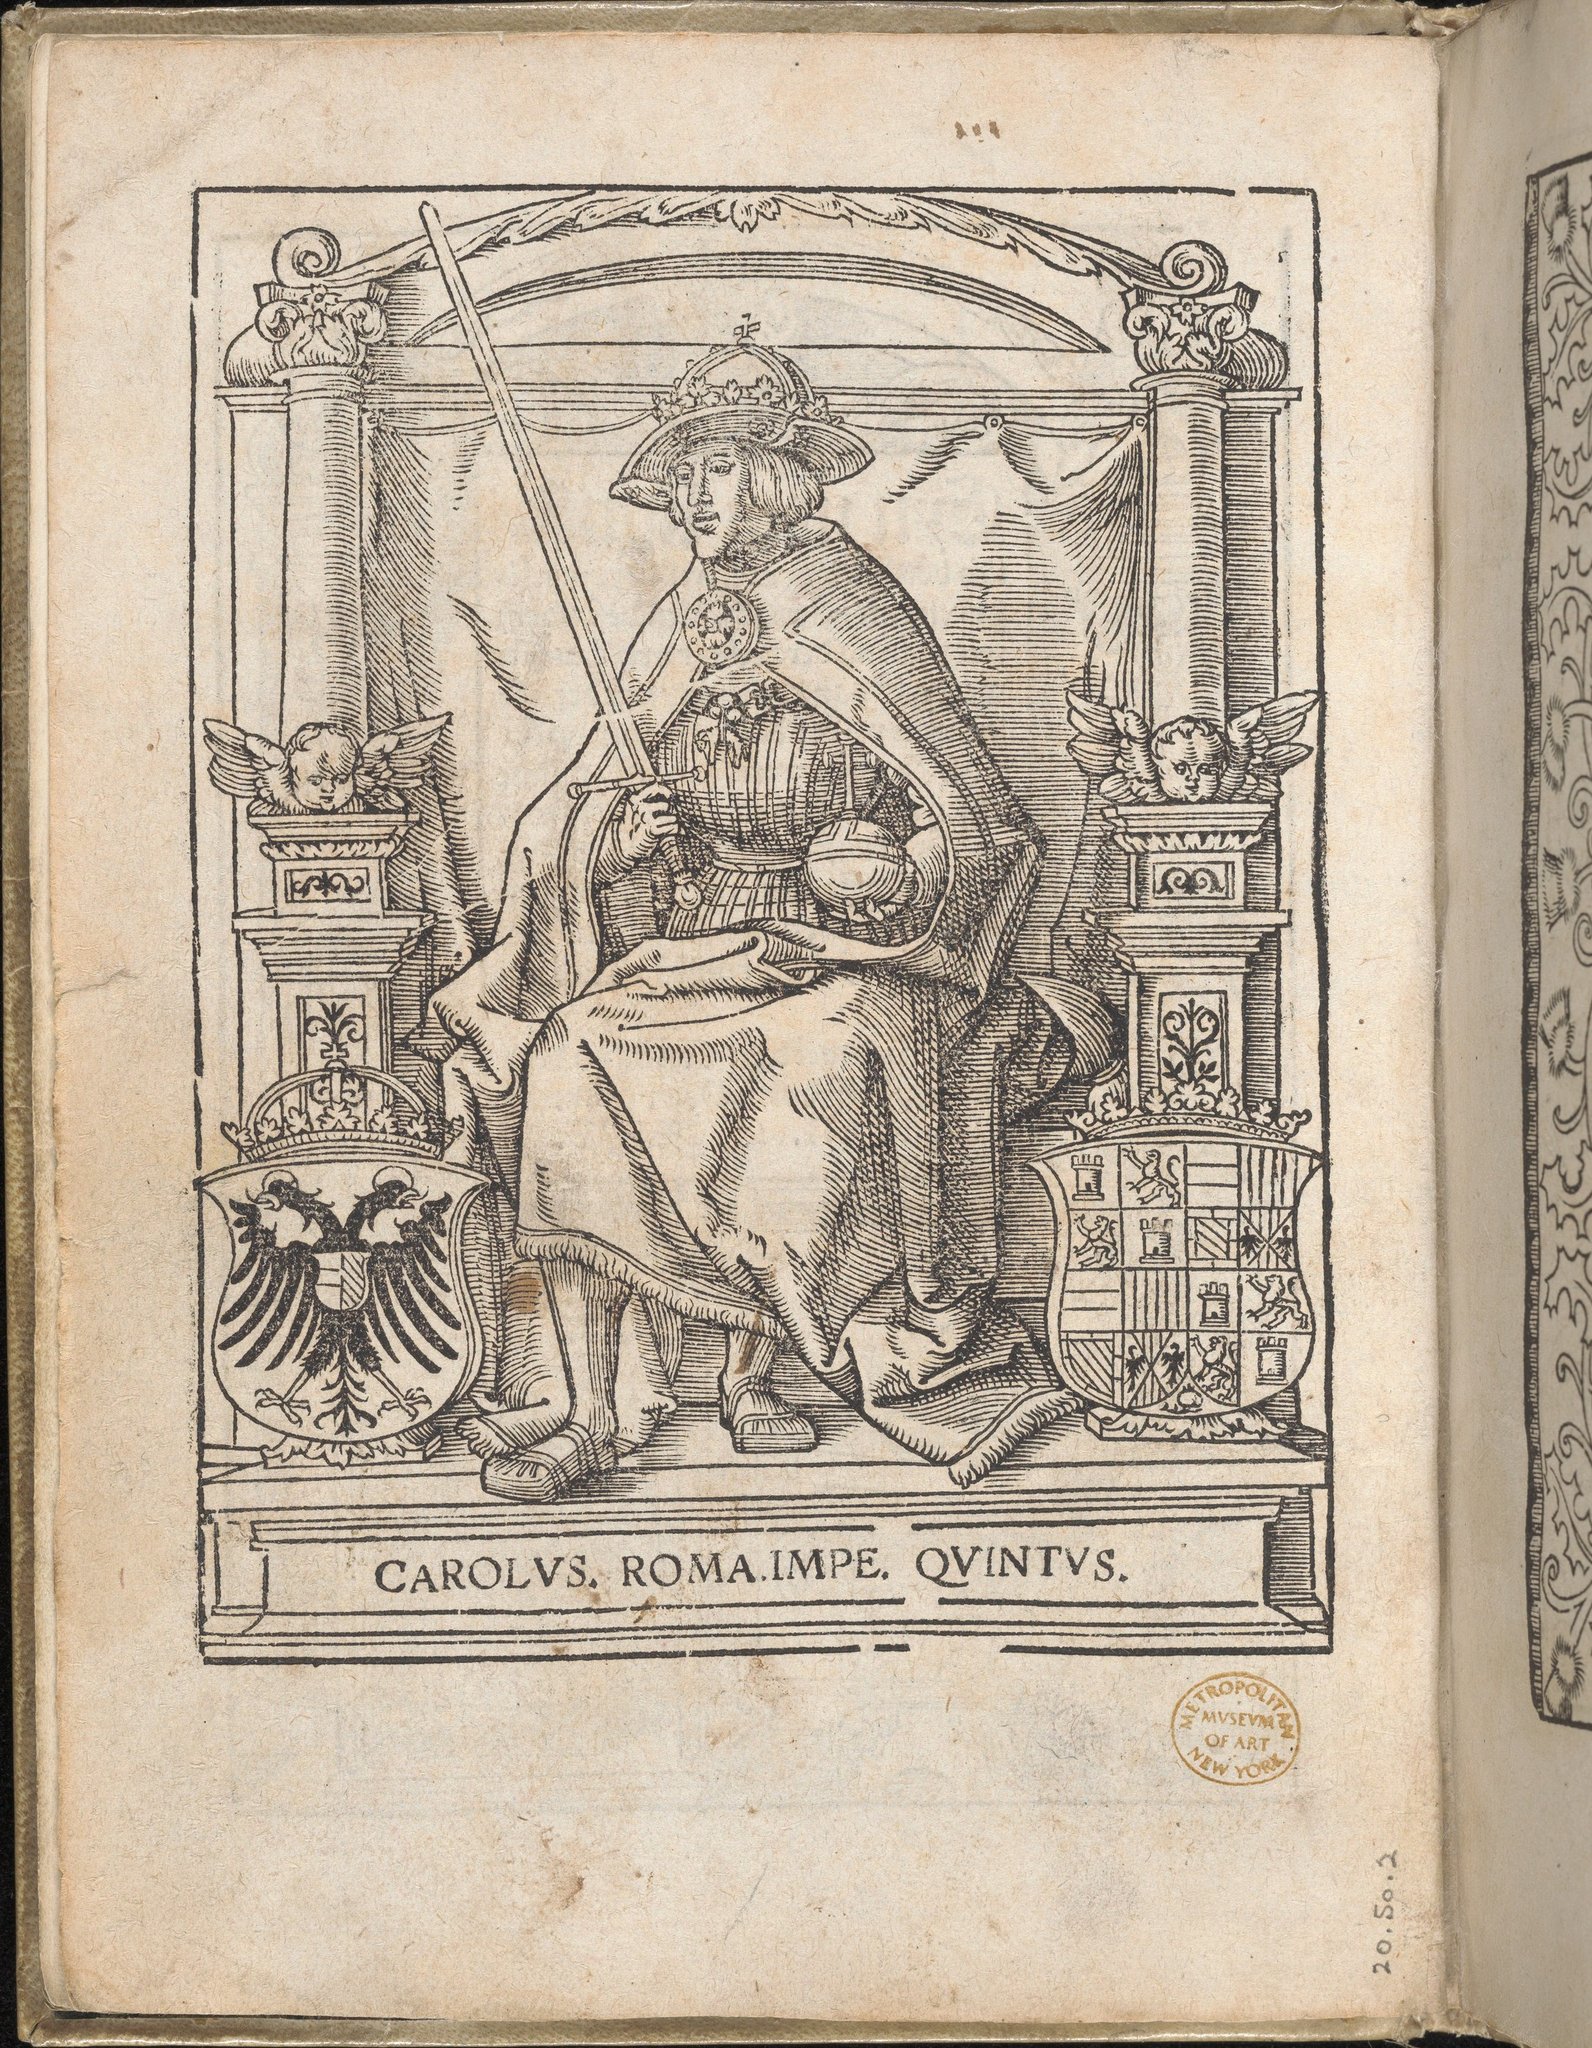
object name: book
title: Page 2 verso, from "Eyn New Kunstlichboich"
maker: peter quentel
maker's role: publisher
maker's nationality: german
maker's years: 1500-1550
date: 1529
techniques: woodcut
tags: swords,kings,portraits,coat of arms